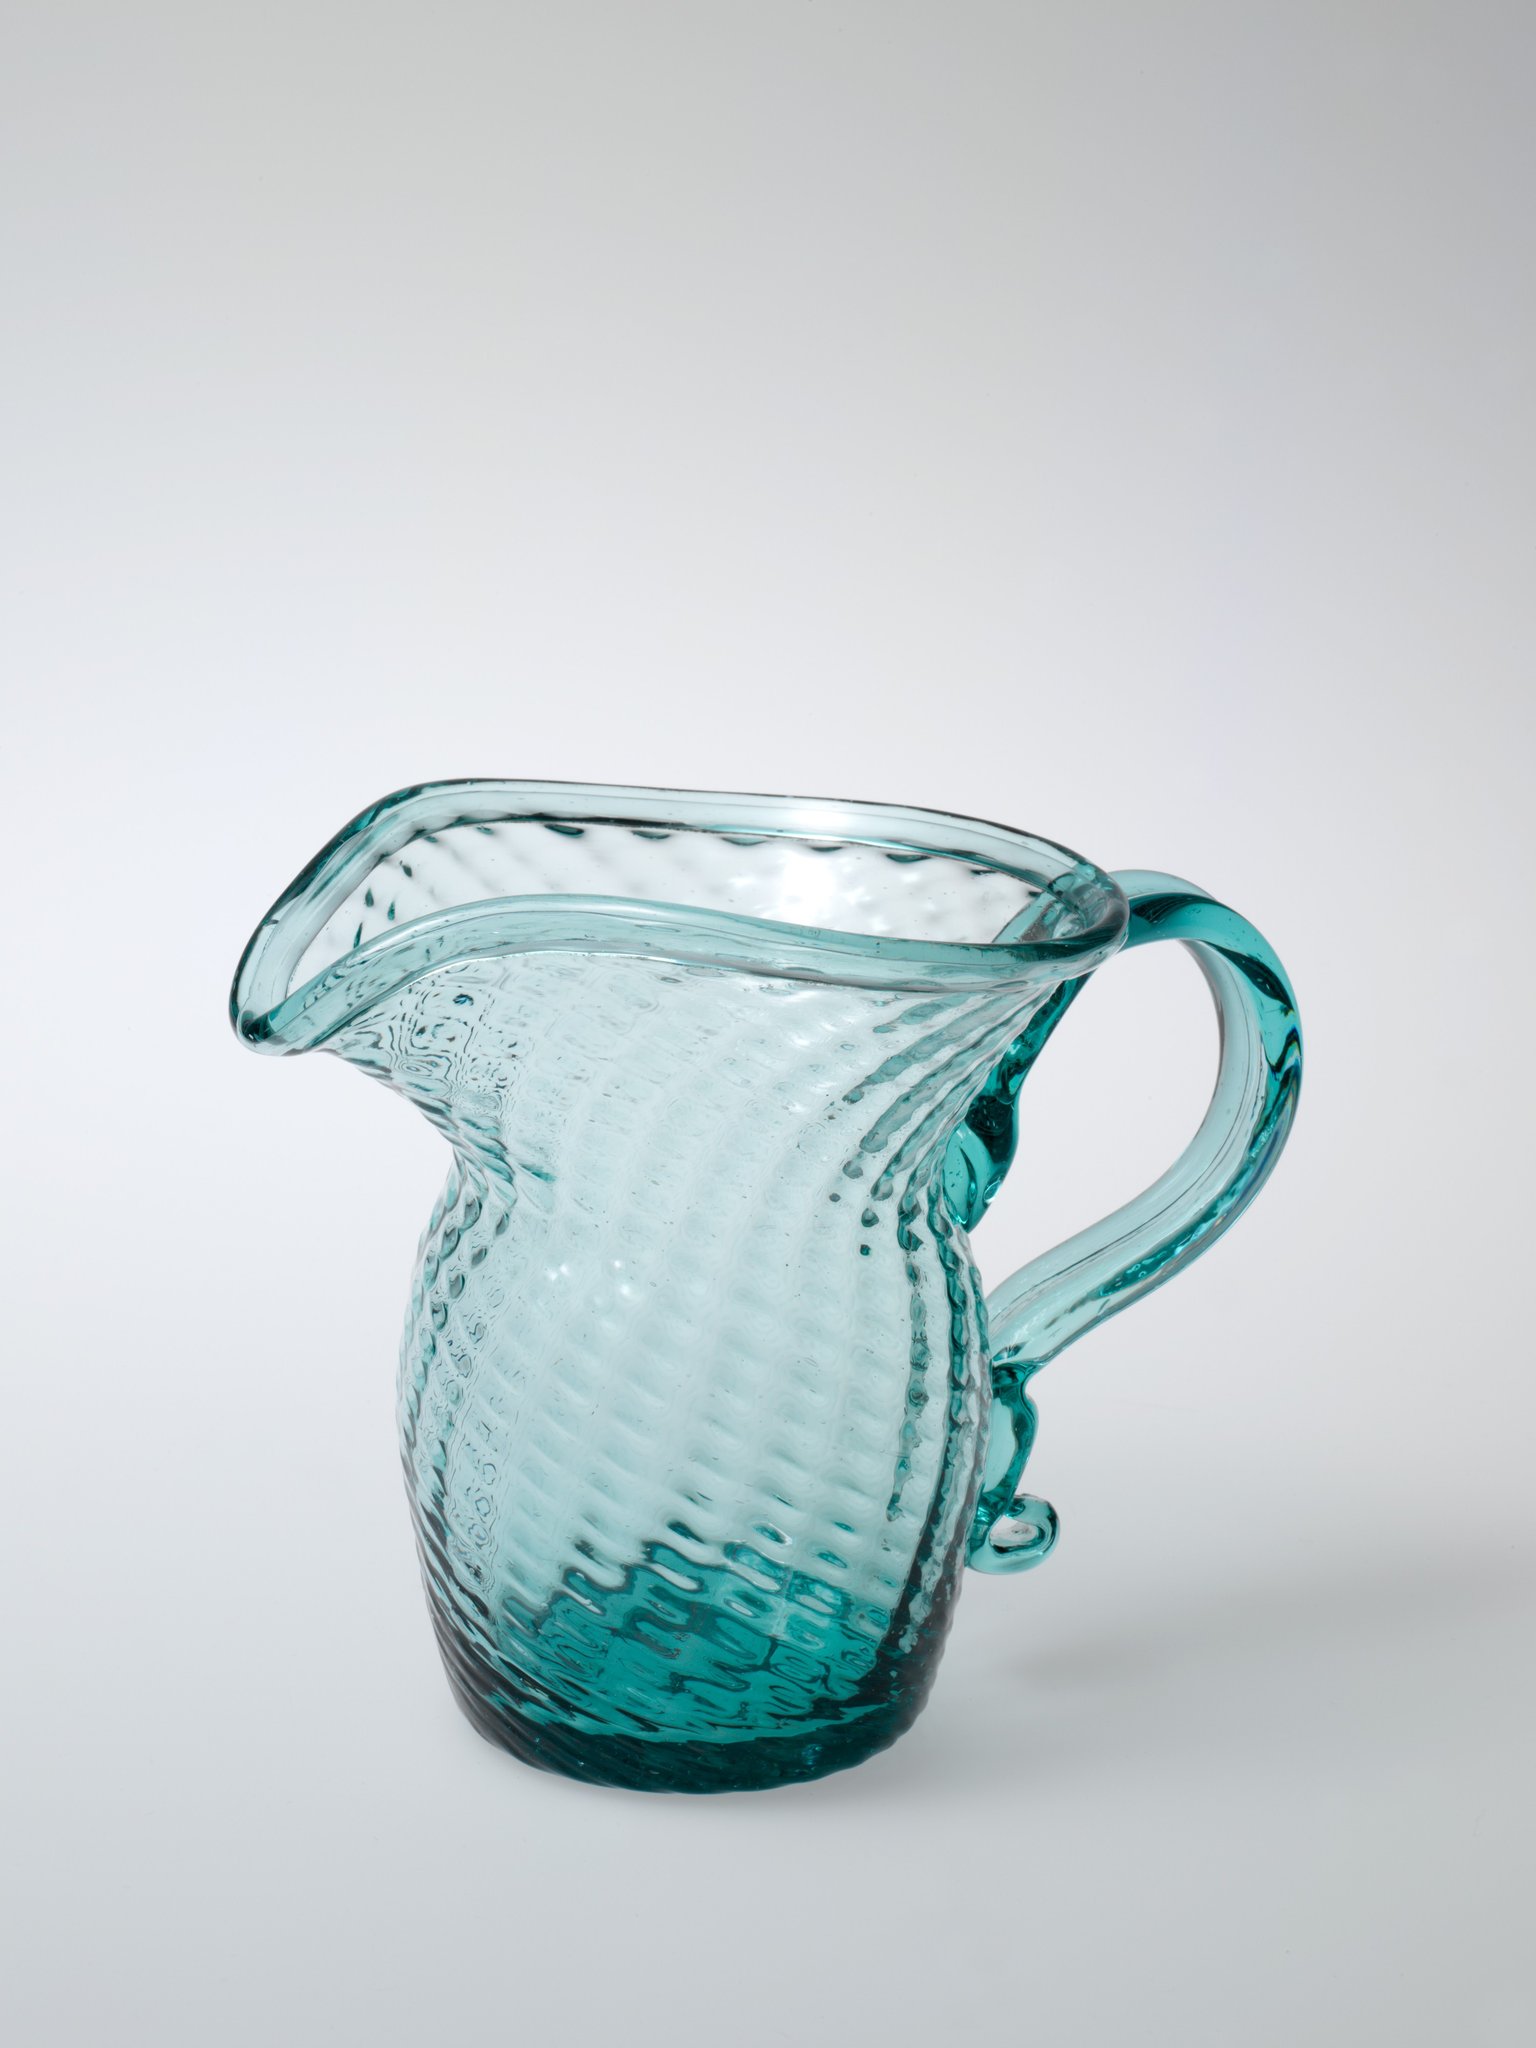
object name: cream pitcher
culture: american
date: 1815-1840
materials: glass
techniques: glassblowing, molding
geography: united states